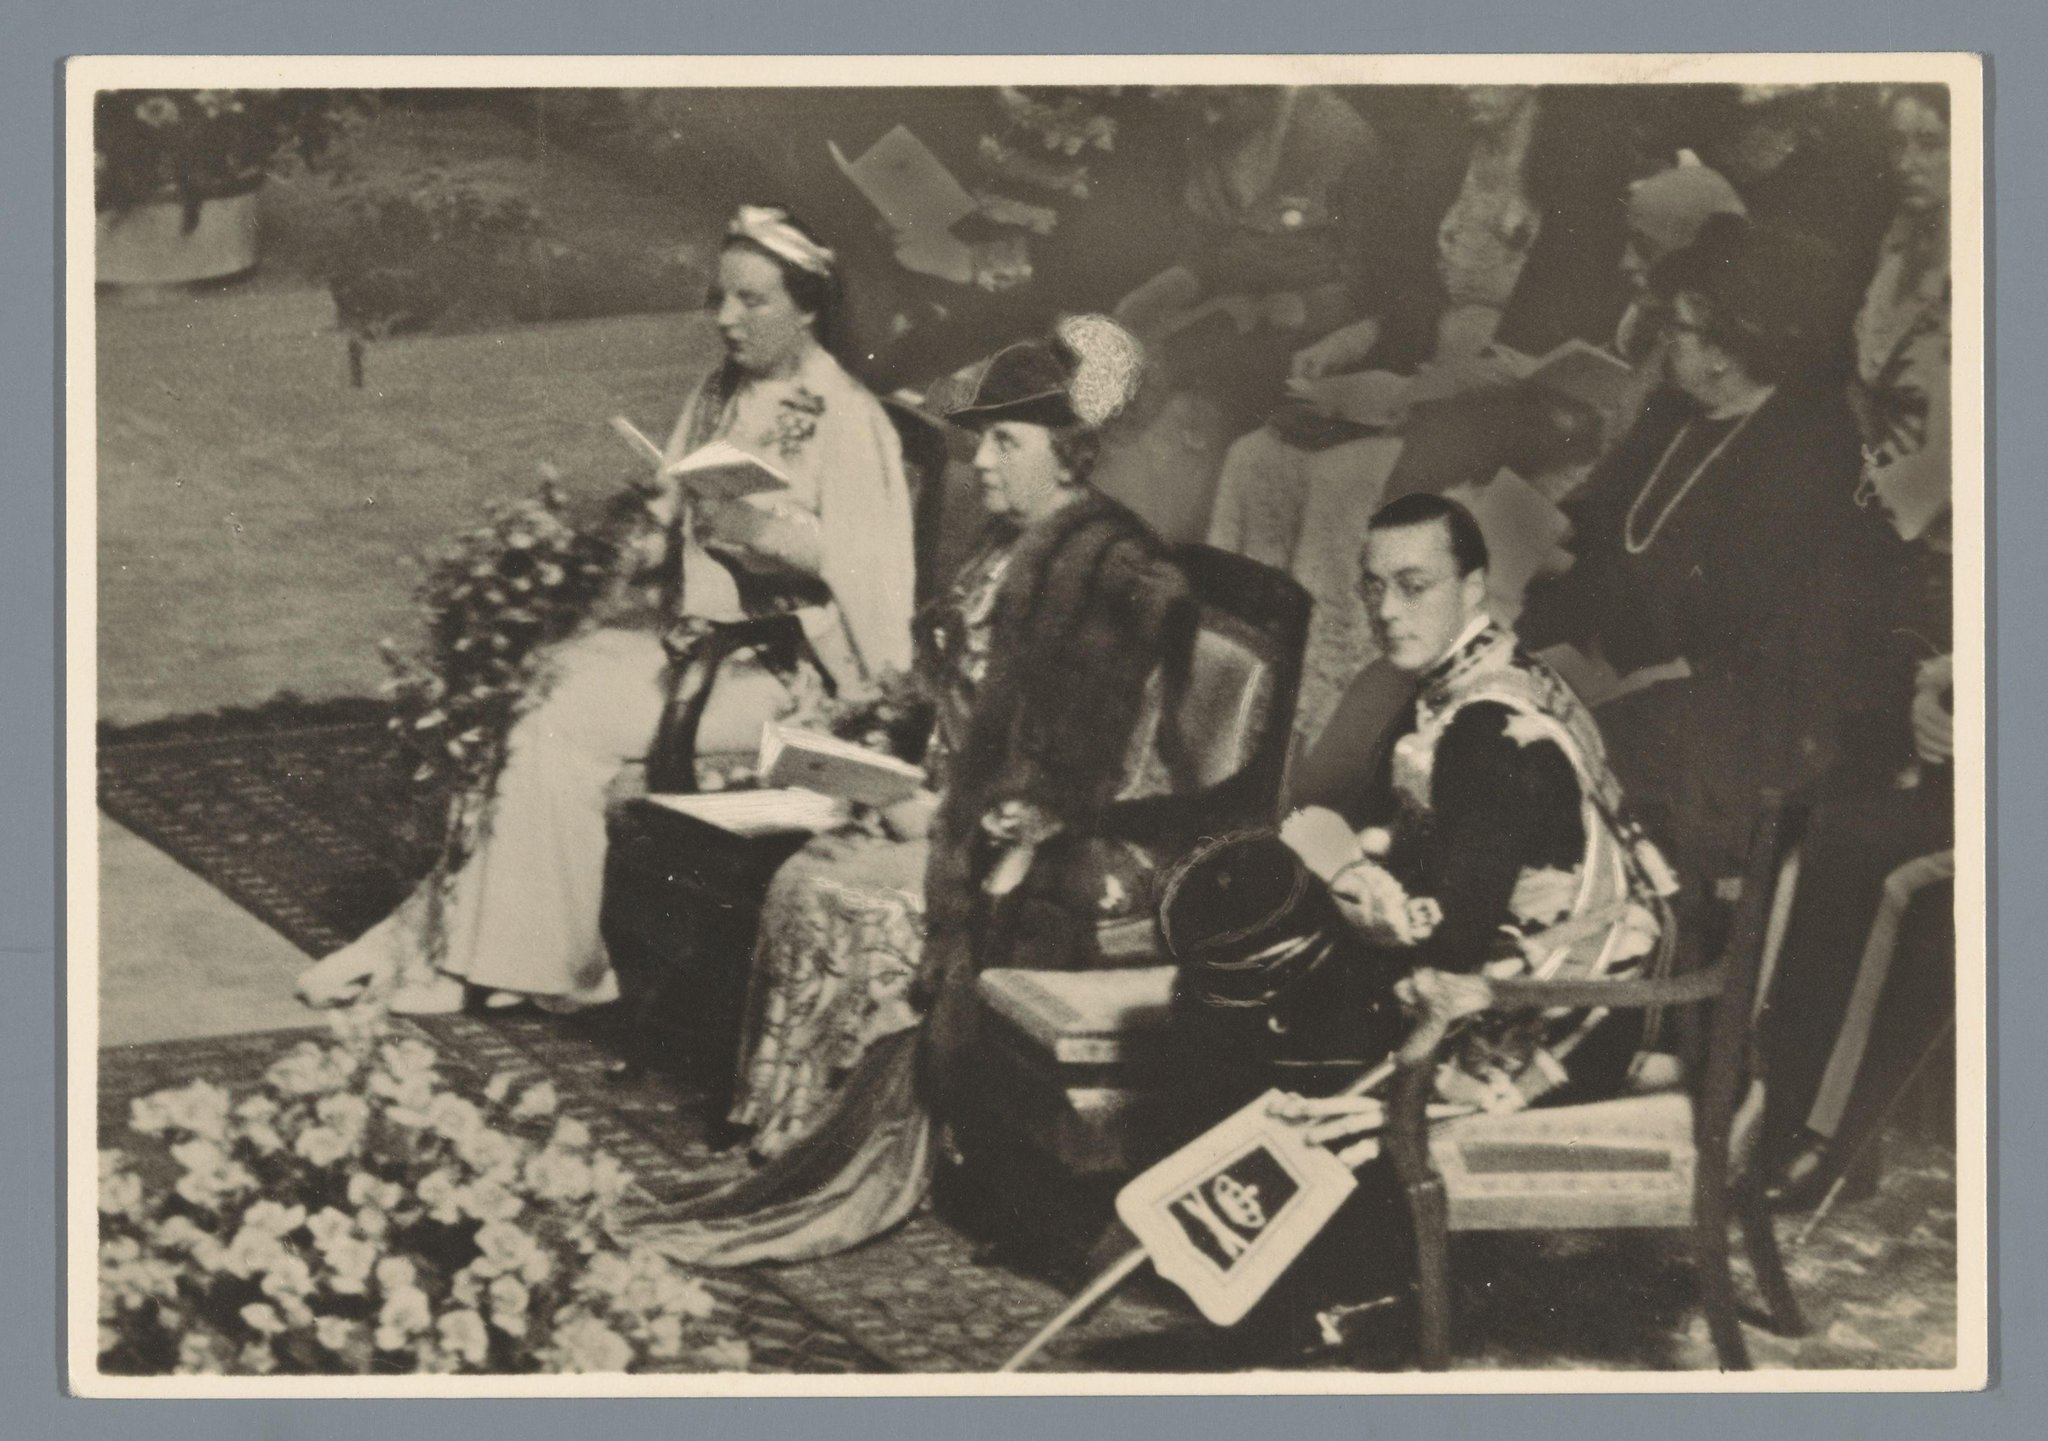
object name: ansichtkaart, prentbriefkaart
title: Nieuwe Kerk, Amsterdam, 6 September 1938. Herdenkingsbijeenkomst ter gelegenheid van het 40- jarig regeeringsjubileum van H.M. de koningin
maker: Anonymous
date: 1938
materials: photographic support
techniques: gelatin silver print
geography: amsterdam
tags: wilhelmina of the netherlands, utrecht, bernhard (prins der nederlanden), the hague, juliana of the netherlands, crown princess, prince, queen